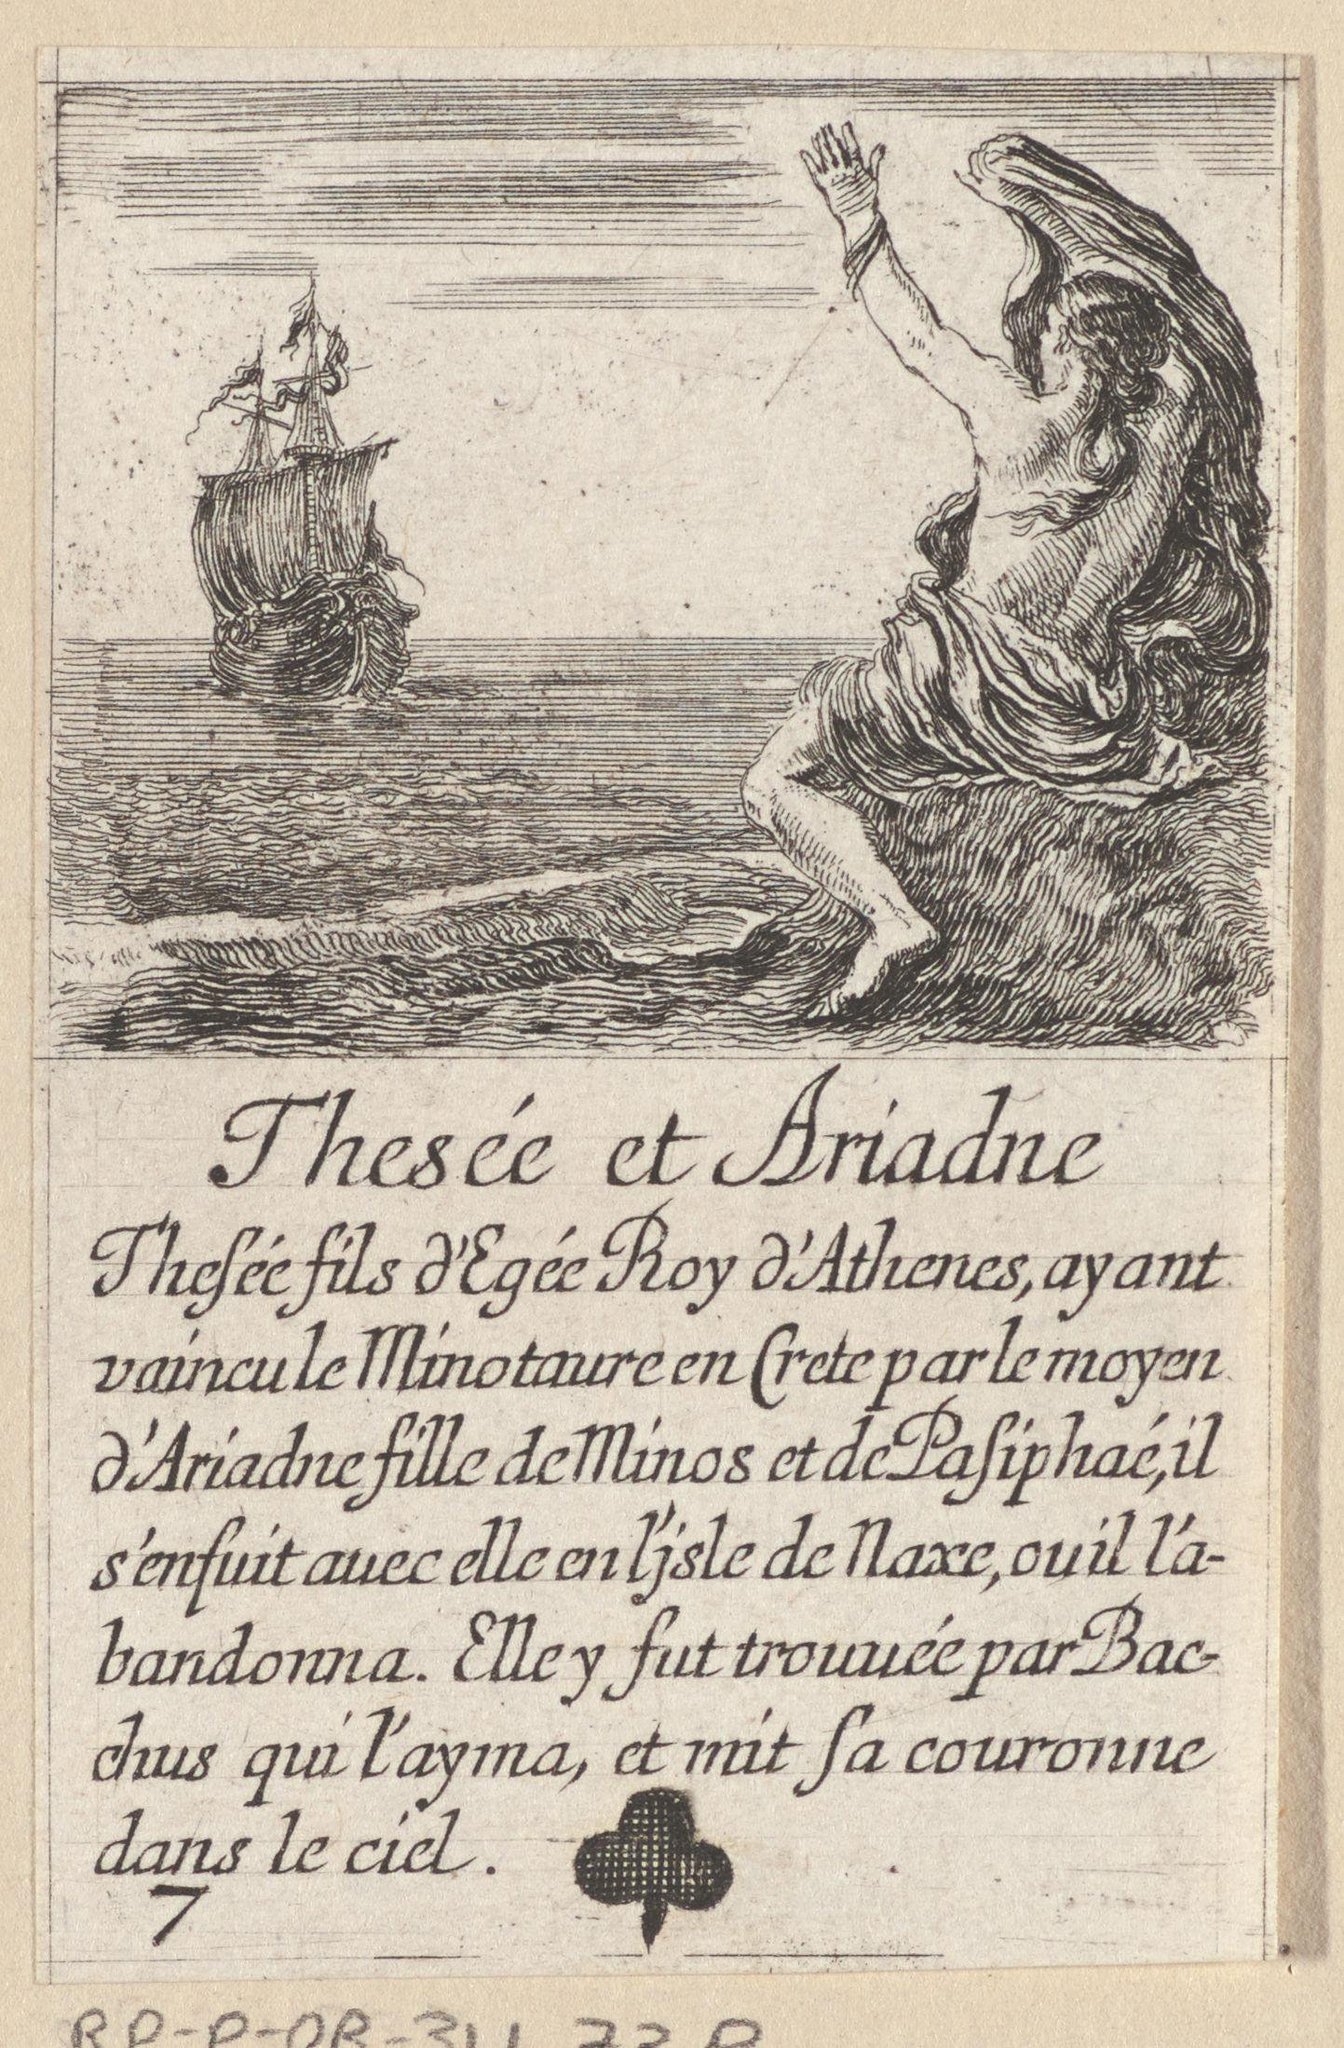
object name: print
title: Theseus en Ariadne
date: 1620-1664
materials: paper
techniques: etching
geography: paris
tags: ariadne left behind on the island of naxos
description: Deze prent maakt deel uit van een kaartspel met 52 kaarten met voorstellingen uit de Metamorfosen van Ovidius. De serie is uitgedacht door Jean Desmarests de Saint-Sorlin in opdracht van Kardinaal Mazarin. Het kaartspel werd gemaakt voor de jonge Lodewijk XIV, samen met het Jeu des Reynes Renommées, Jeu de la Géographie en Jeu des Rois de France.